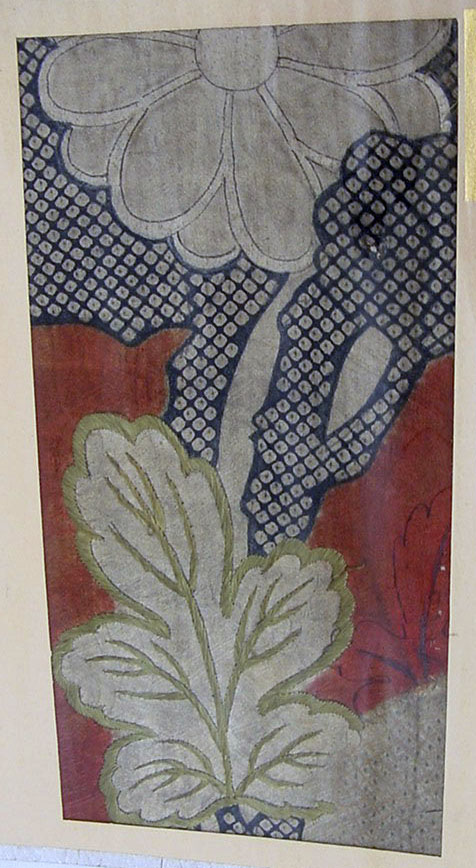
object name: piece from a kosode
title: Piece from a Kosode with Partial Chrysanthemum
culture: japanese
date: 1615-1868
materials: silk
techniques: damask, dyeing, embroidery, resist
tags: flowers